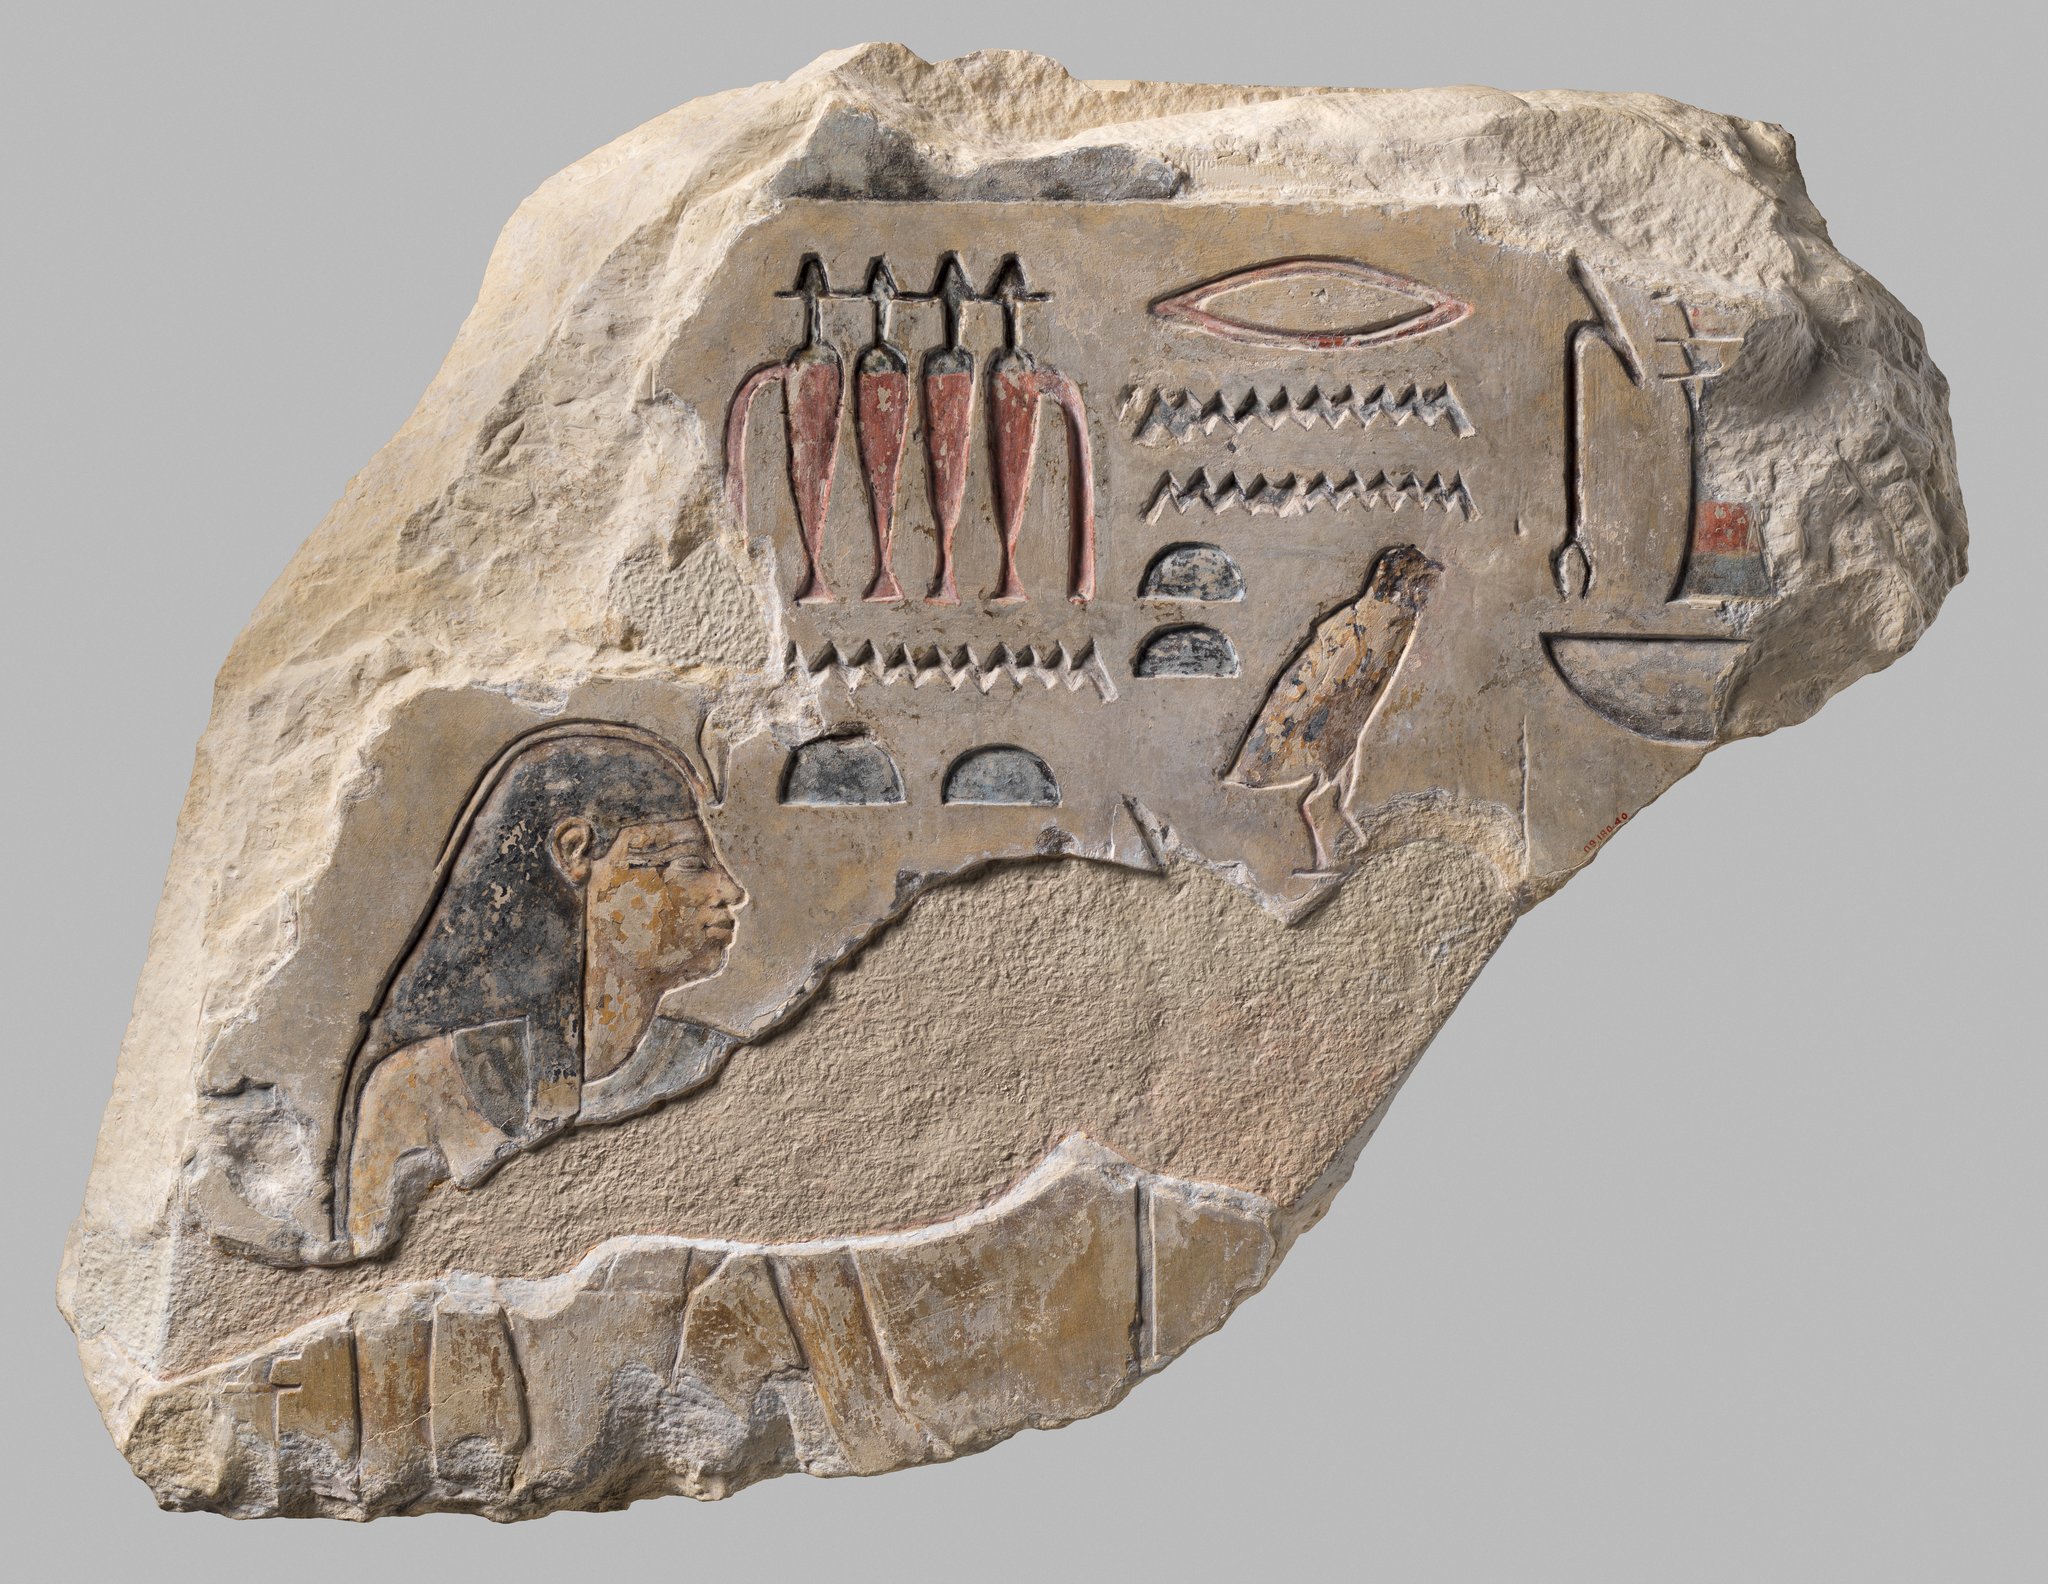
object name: relief, senwosret i, deity procession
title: Relief of Renenutet, represented as a woman, from a deity procession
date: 1961-1917 BCE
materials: limestone, paint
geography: egypt